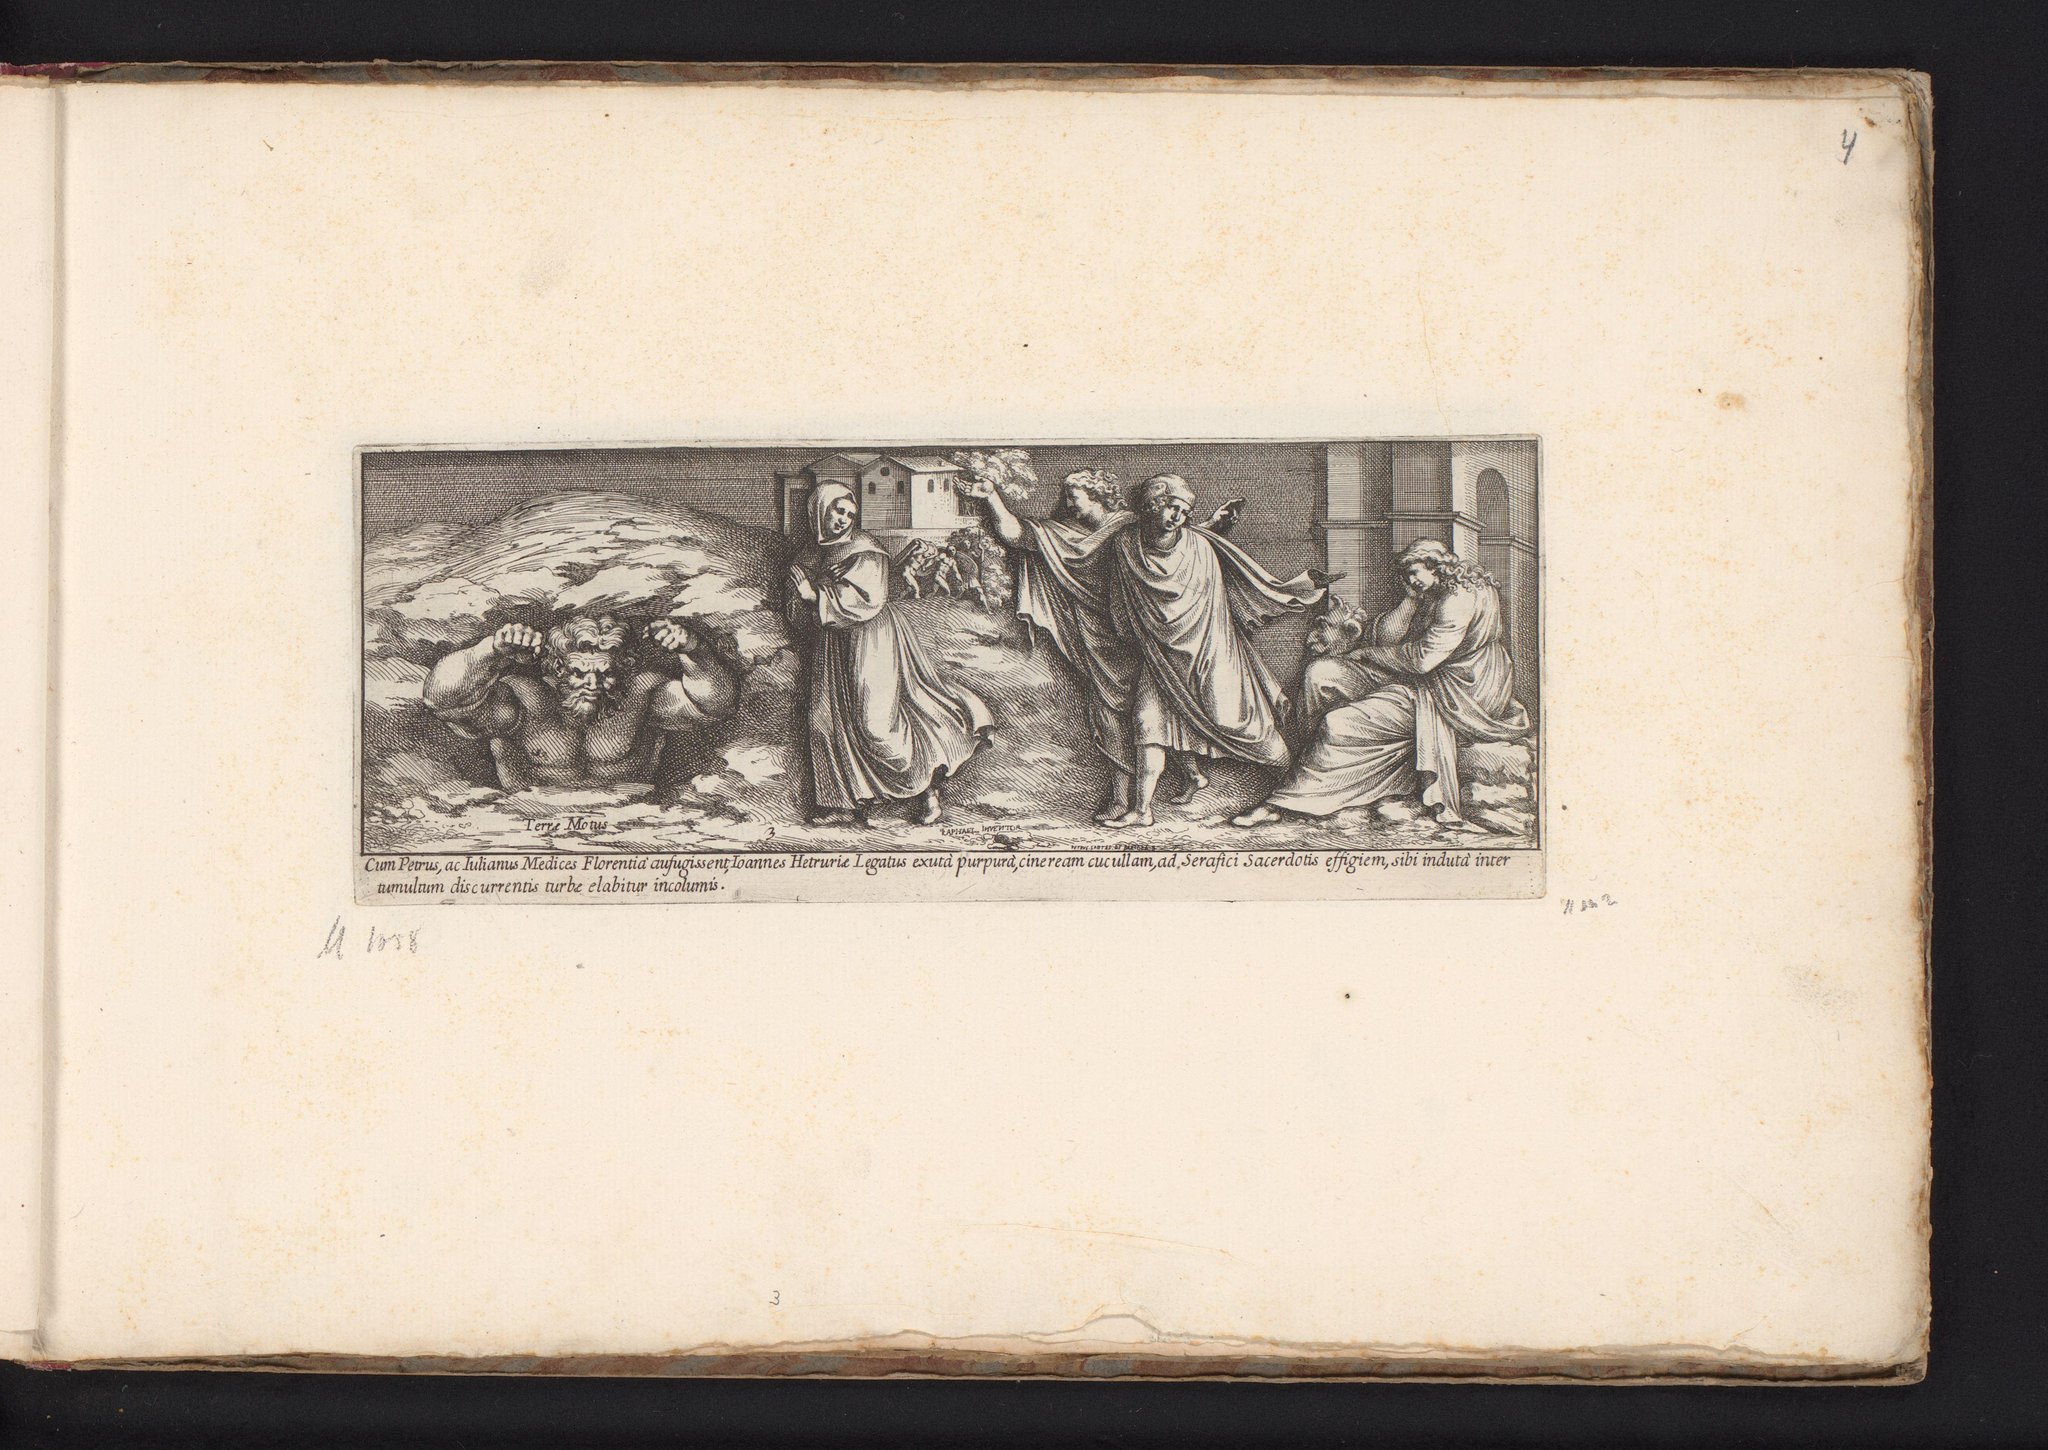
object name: print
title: Scènes uit het leven van paus Leo X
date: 1645-1700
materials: paper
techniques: engraving, etching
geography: vatican city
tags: leo x, flight, running away; pursuing, disguise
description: Giovanni de' Medici vlucht weg uit Florence, verkleed als een monnik. Links een reus in een grot. Titel in ondermarge. Genummerd midden onder: 3. Prent maakt deel uit van een album.